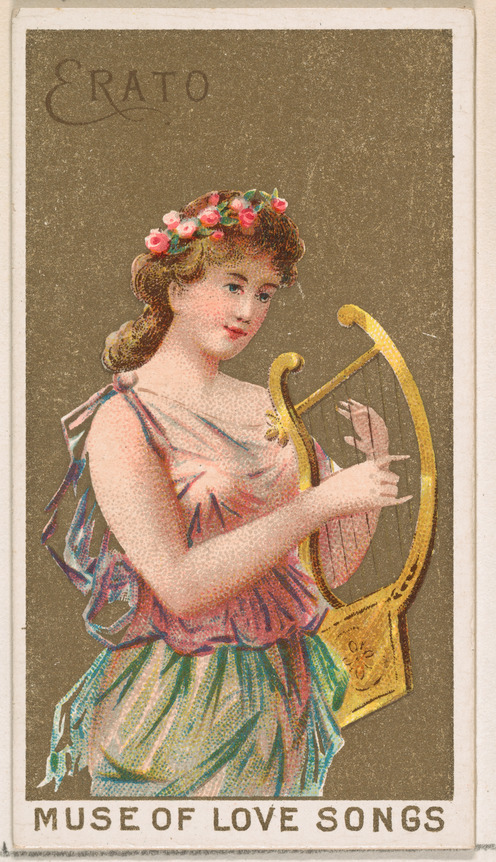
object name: print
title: Erato, Muse of Love Songs, from the Goddesses of the Greeks and Romans series (N188) issued by Wm. S. Kimball & Co.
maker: william s. kimball & company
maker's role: publisher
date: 1889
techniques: color lithograph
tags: women,lyres